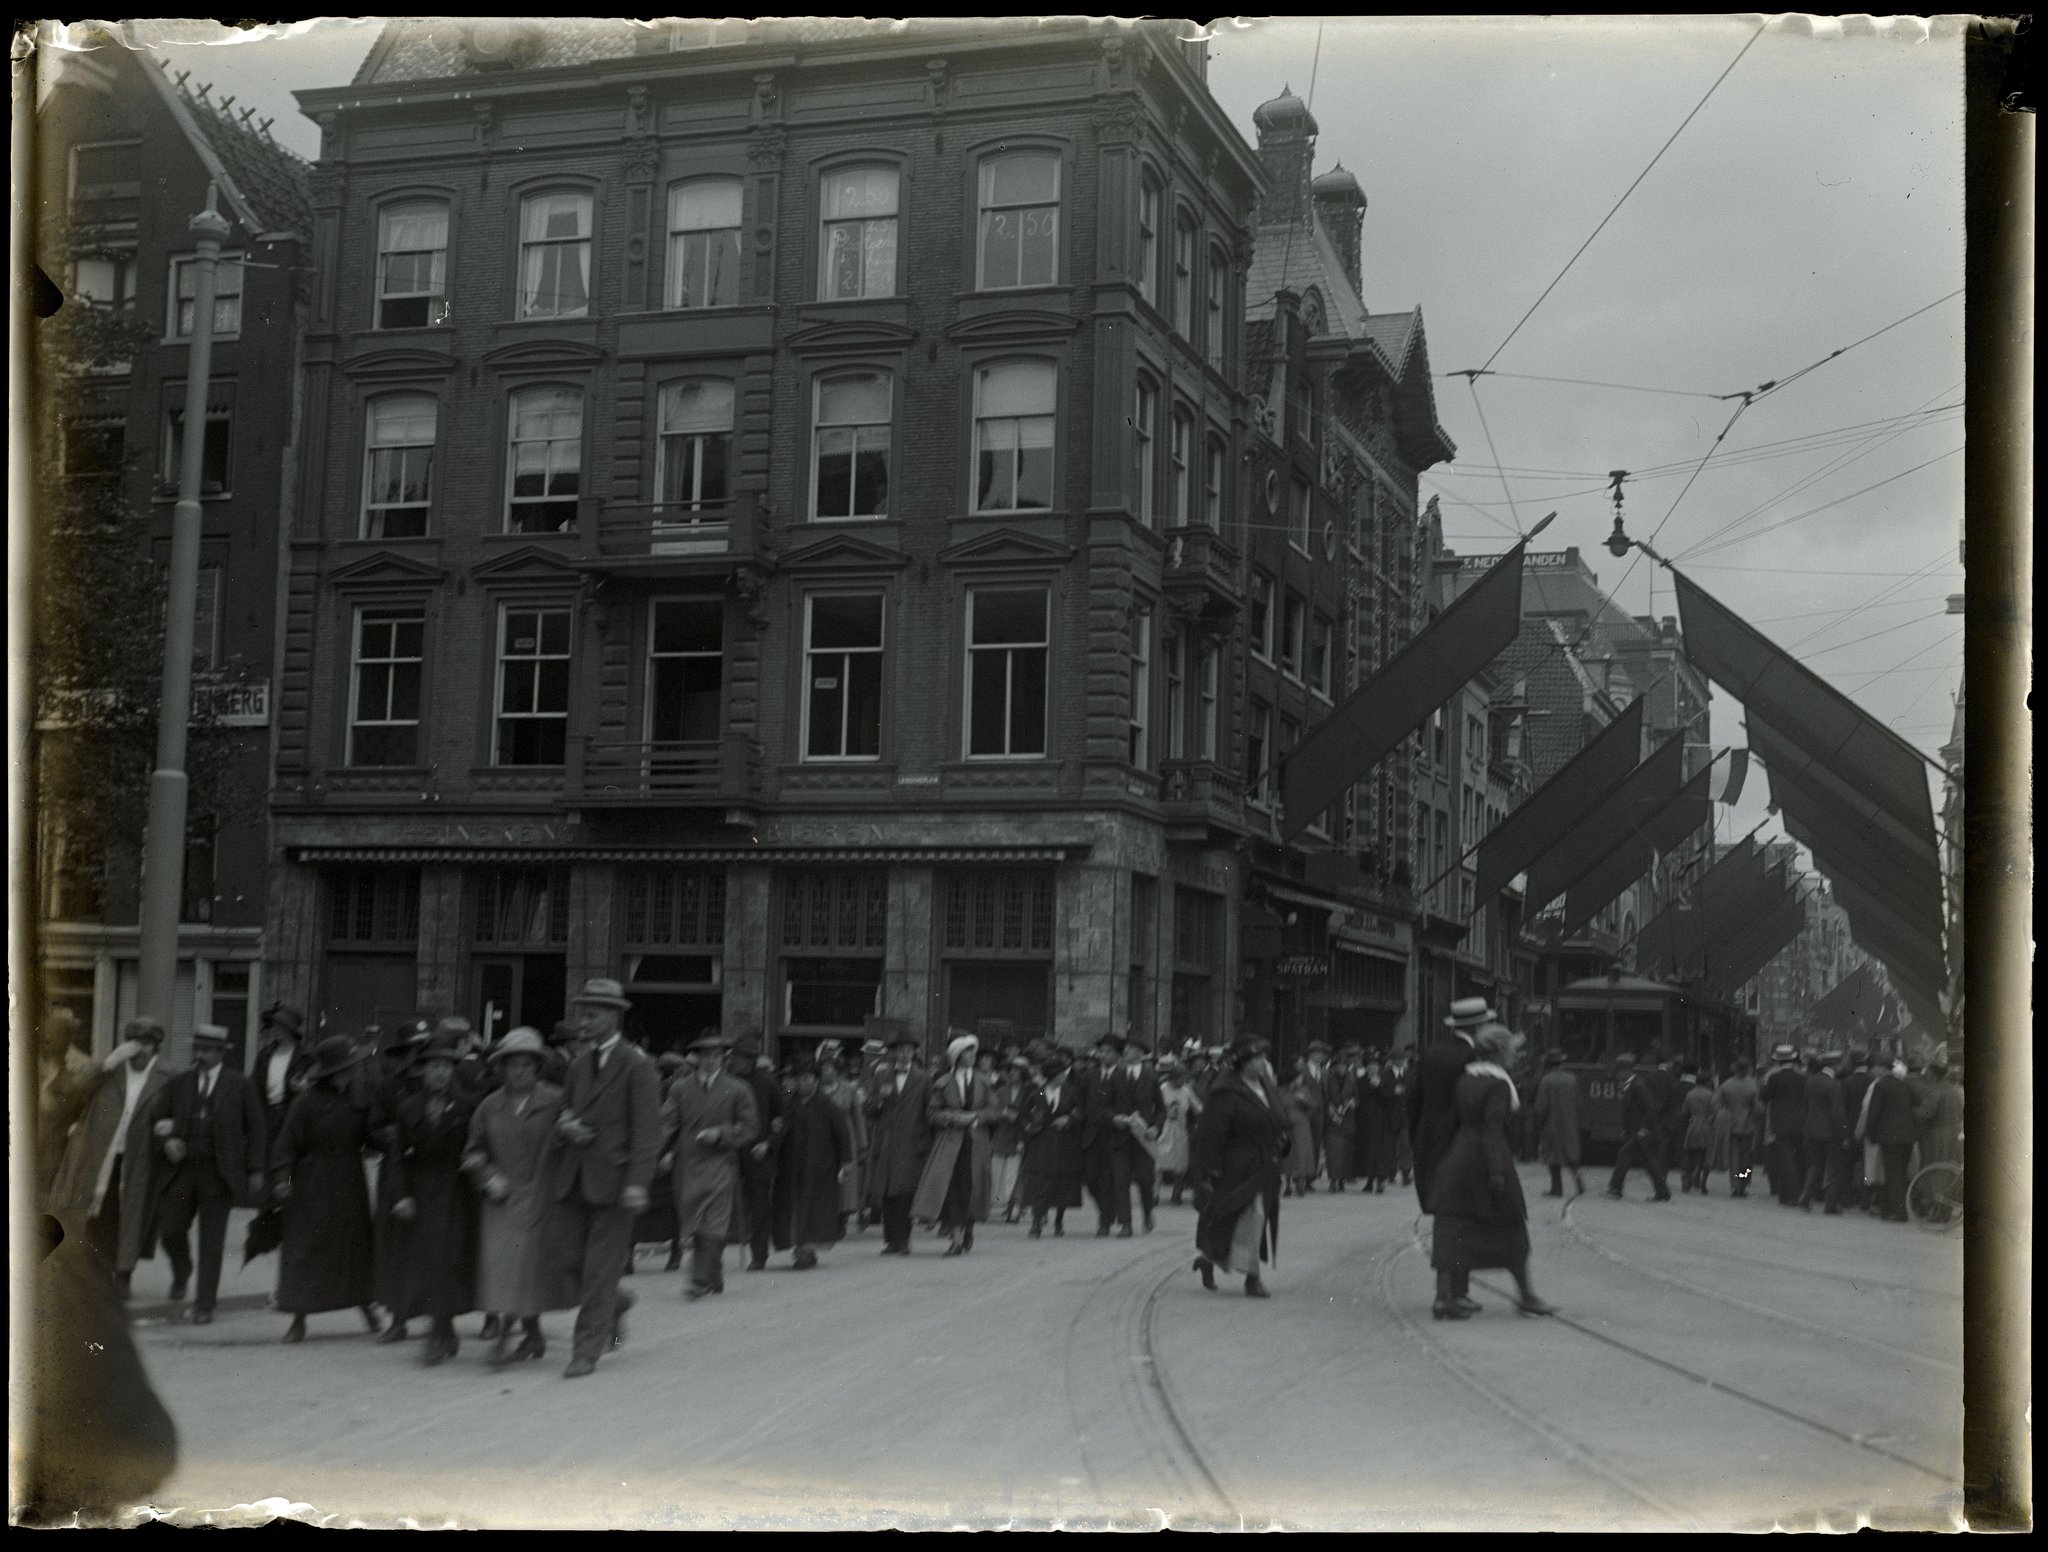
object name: glasnegatief, glasplaatnegatief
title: Feest voor het zilveren regeringsjubileum van Koningin Wilhelmina, op de hoek van het Leidseplein en de Leidsestraat, Amsterdam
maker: Anonymous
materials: glass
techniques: gelatin glass negative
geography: amsterdam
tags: public festivities on the occasion of royal events, street